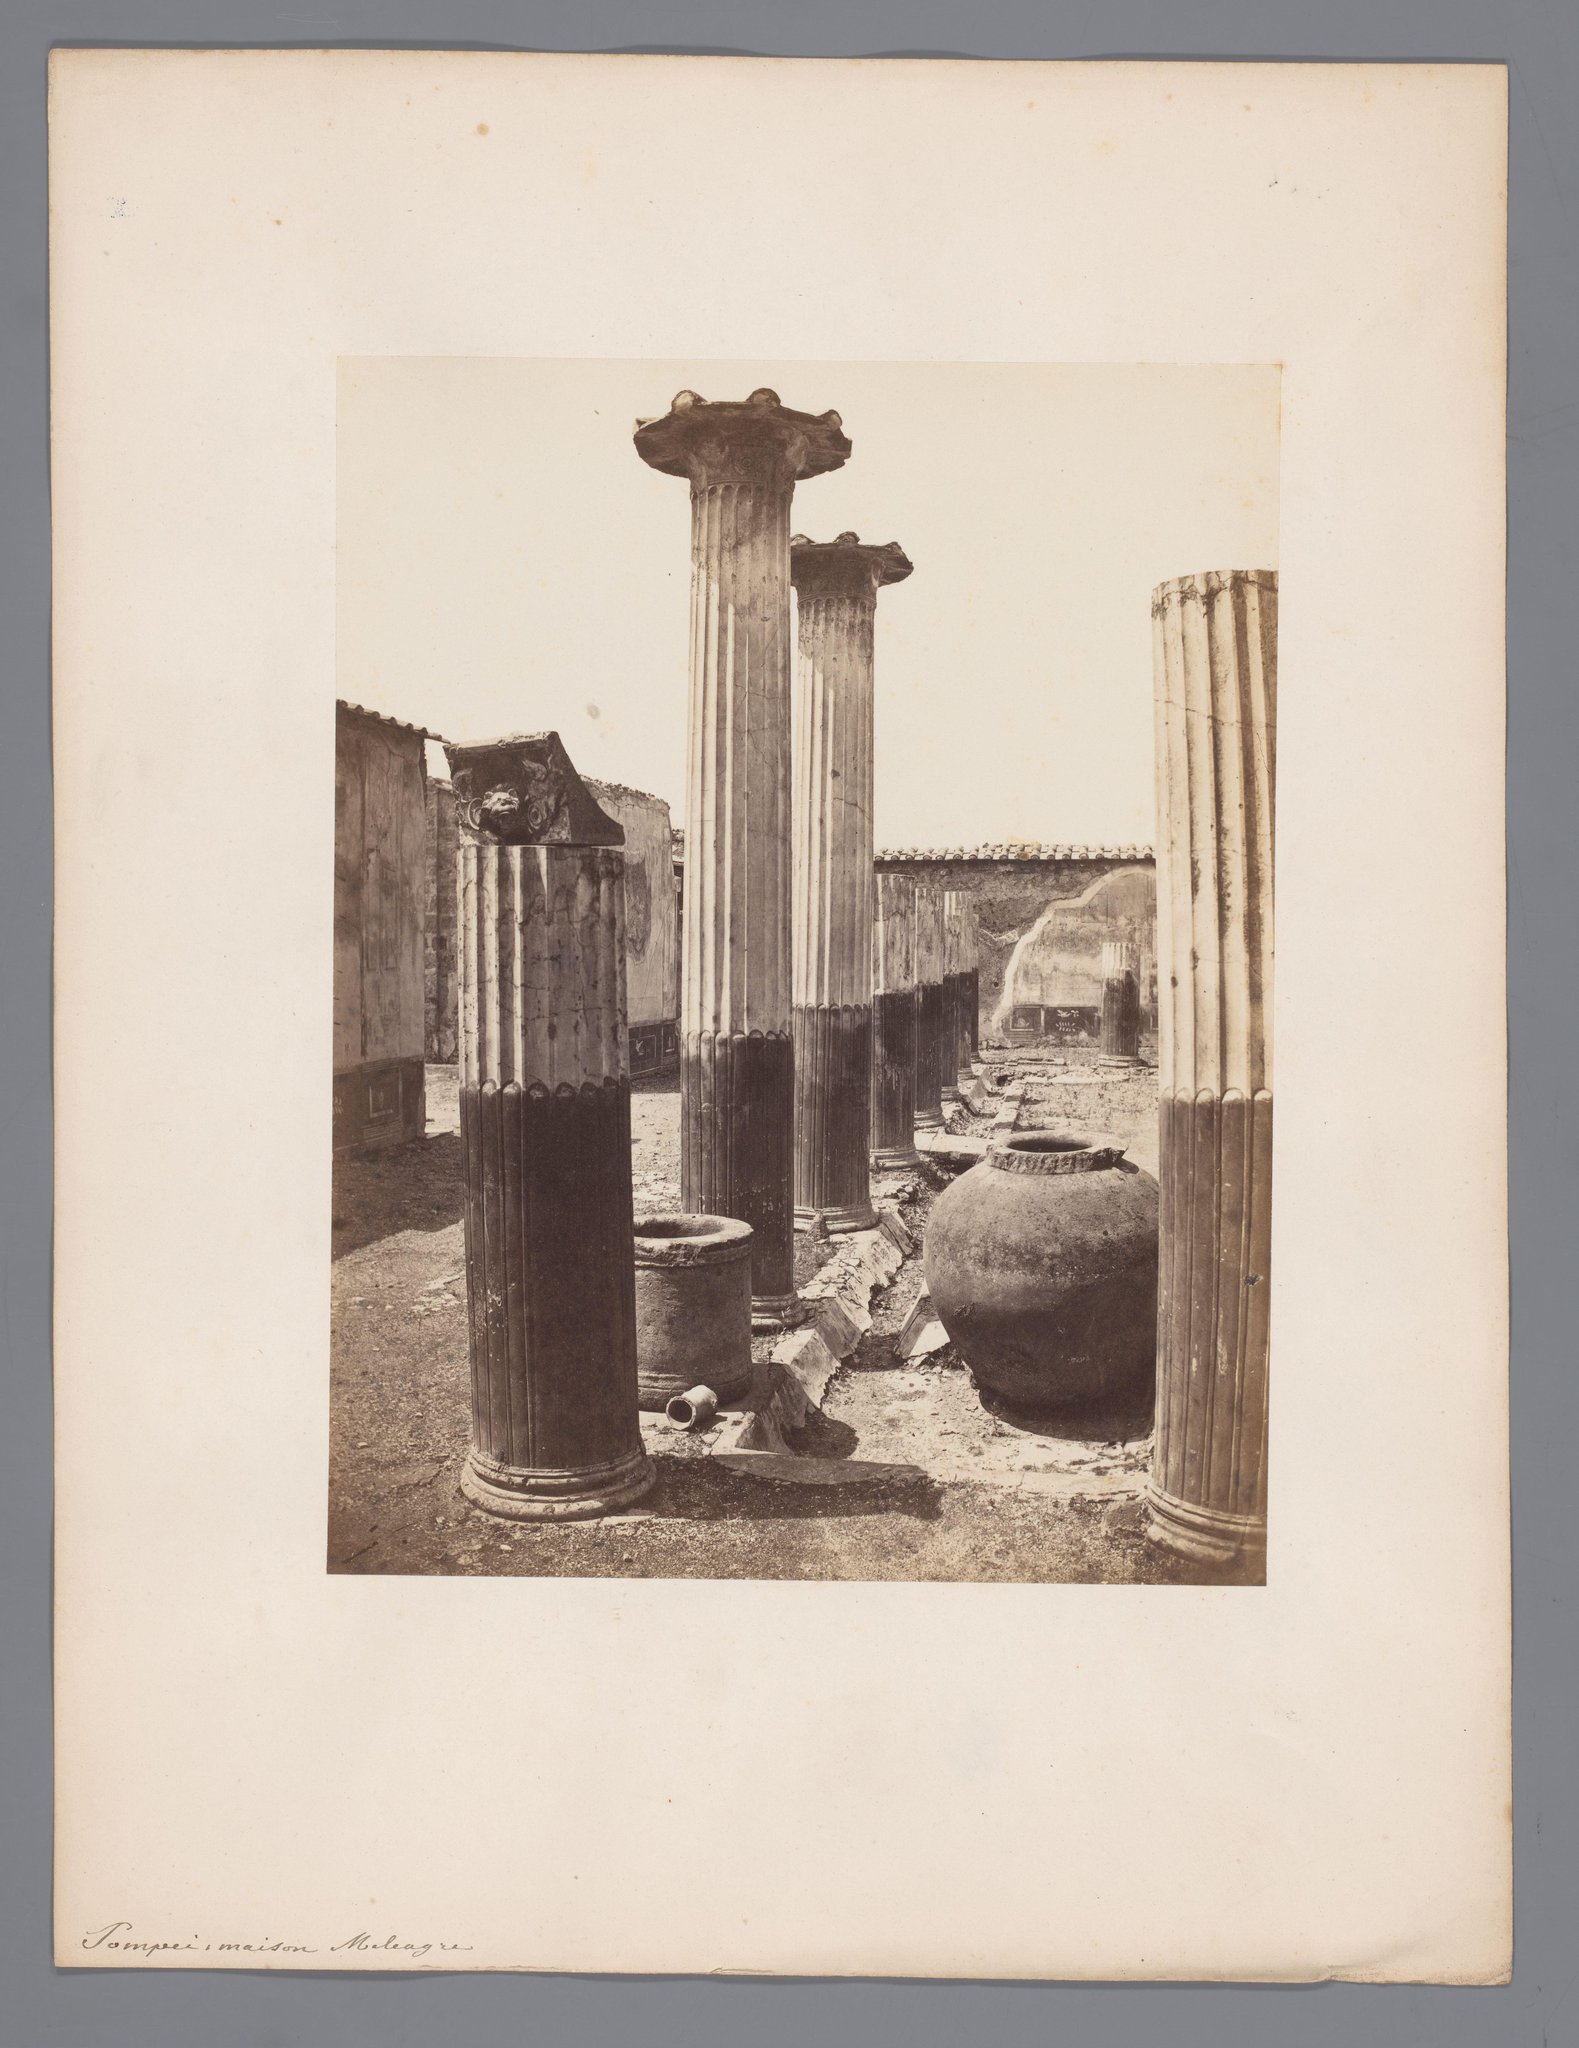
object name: photograph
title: Restanten van het huis van Meleager te Pompeï, Italië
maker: Anonymous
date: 1851-1900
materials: cardboard, paper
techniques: albumen print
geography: pompeii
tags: ruin of a dwelling, house, castle, etc., pompeii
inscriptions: number: ‘11’, inscription: ‘Pompei, maison Meleagre’, number: ‘48’